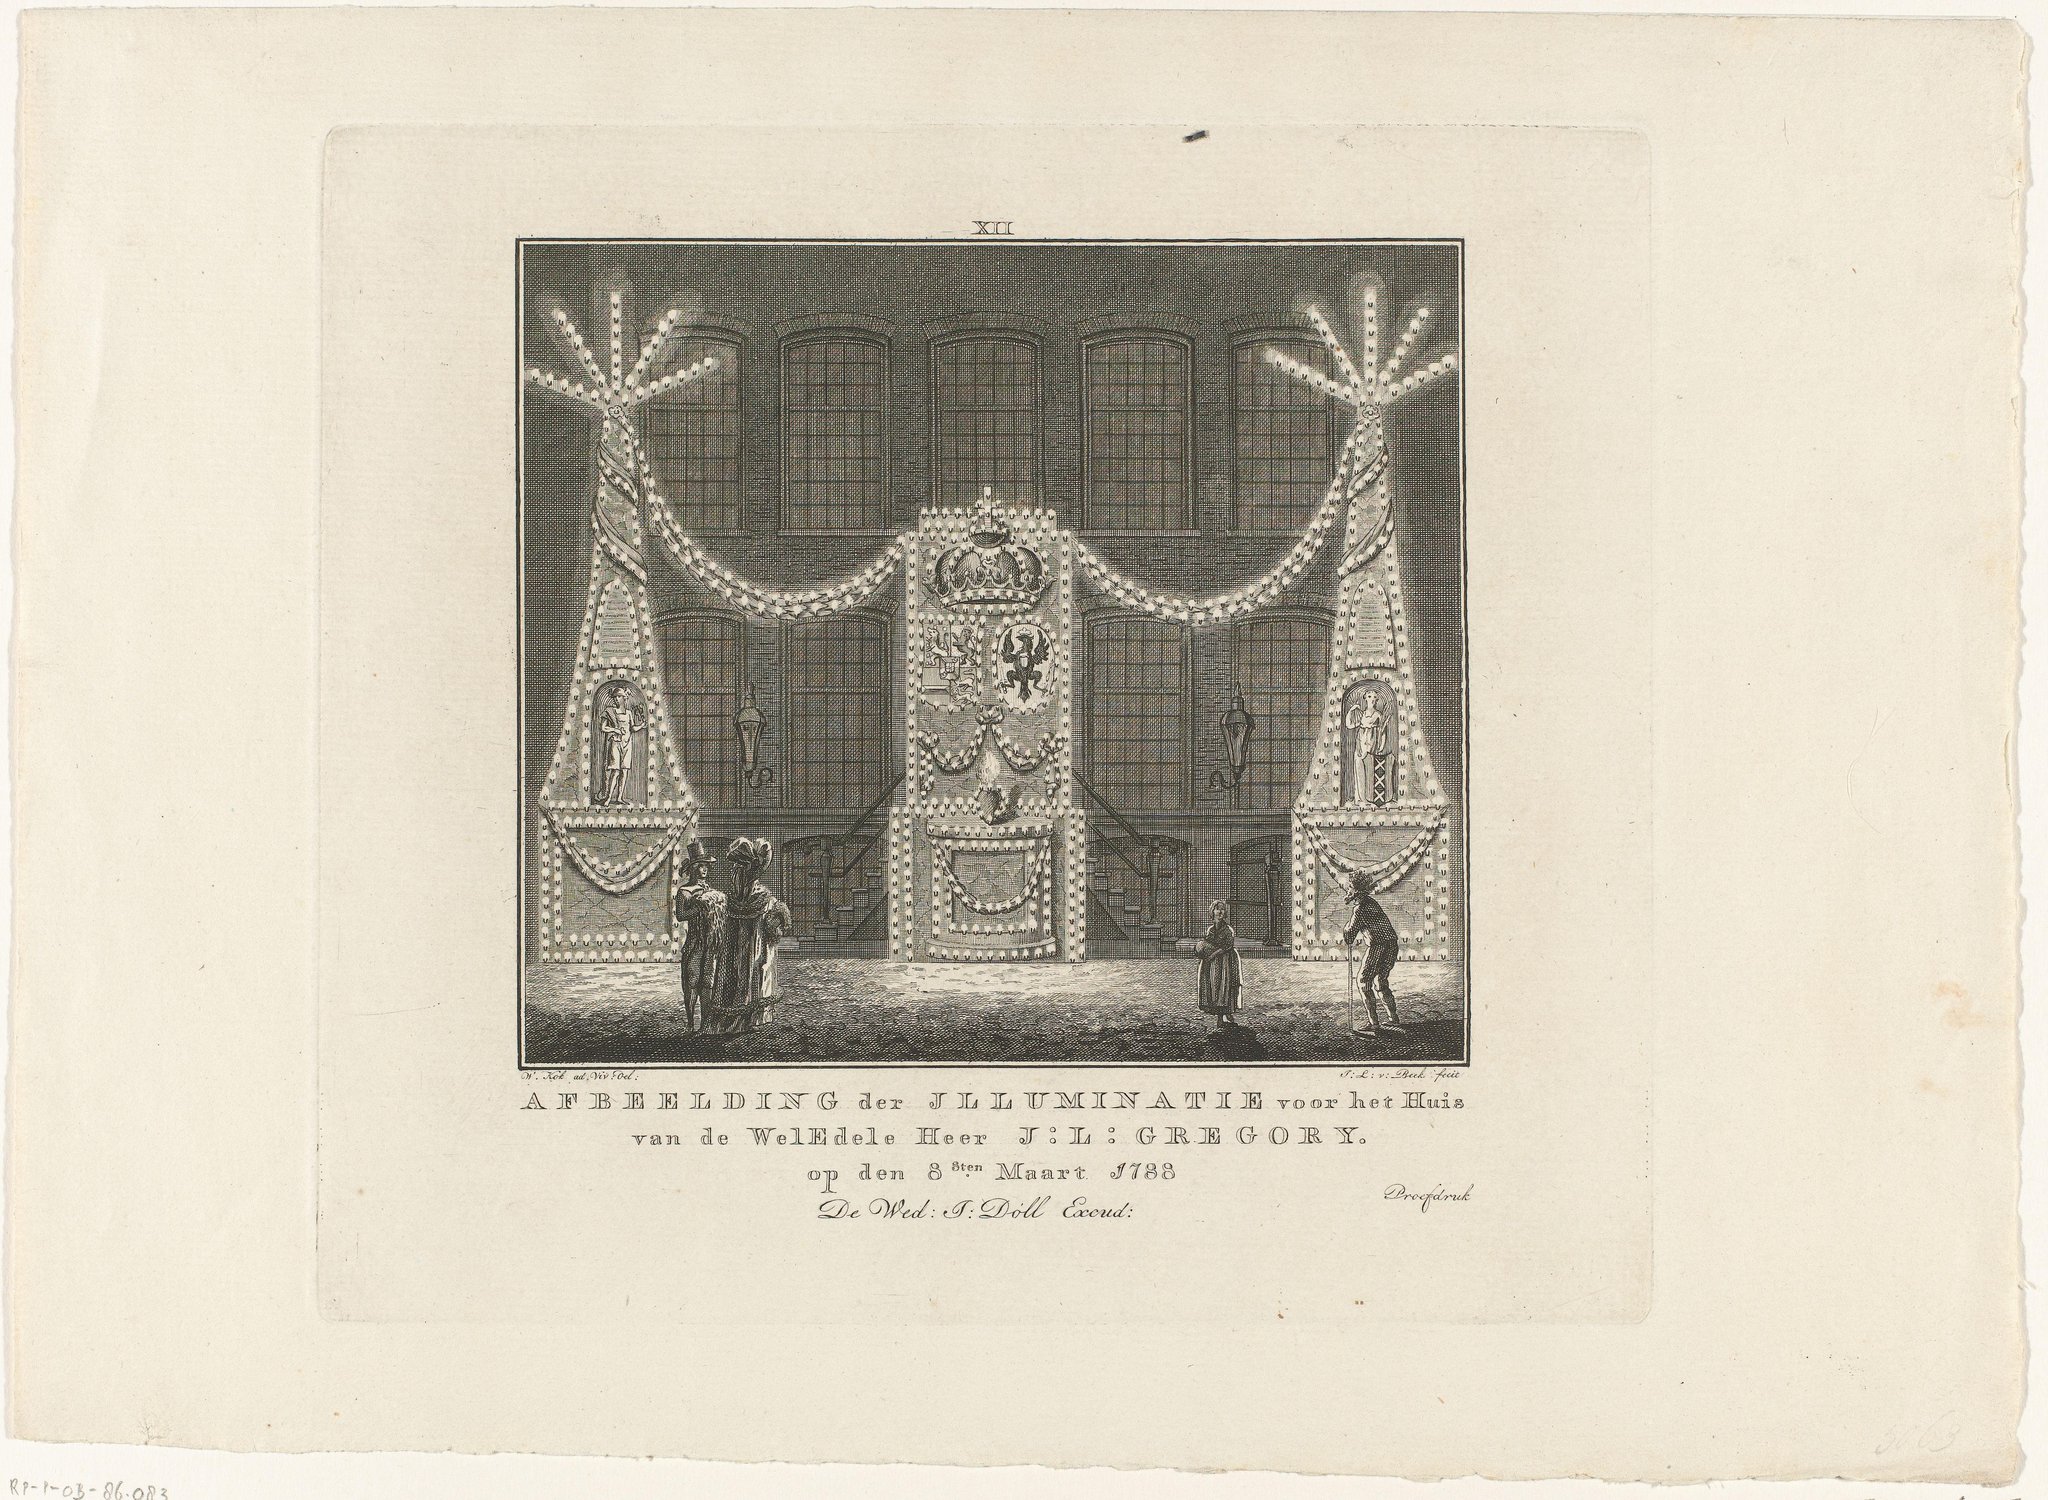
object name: print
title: Illuminatiën en decoratiën te Amsterdam op de 40ste verjaardag van prins Willem V in 1788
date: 1788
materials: paper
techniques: engraving, etching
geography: amsterdam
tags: william v (prince of orange), bonfire, fire-works (+ illumination, fire-works ~ festive activities), amsterdam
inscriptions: collector's mark: Lugt 2228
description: Illuminatie aangebracht voor het huis genaamd de Bonte Mantel, van J.L. Gregory, Herengracht 270 te Amsterdam. Genummerd bovenaan: XII. Onderdeel van een reeks van twaalf platen van de illuminaties en decoraties te Amsterdam op de 40ste verjaardag van prins Willem V op 8 maart 1788.